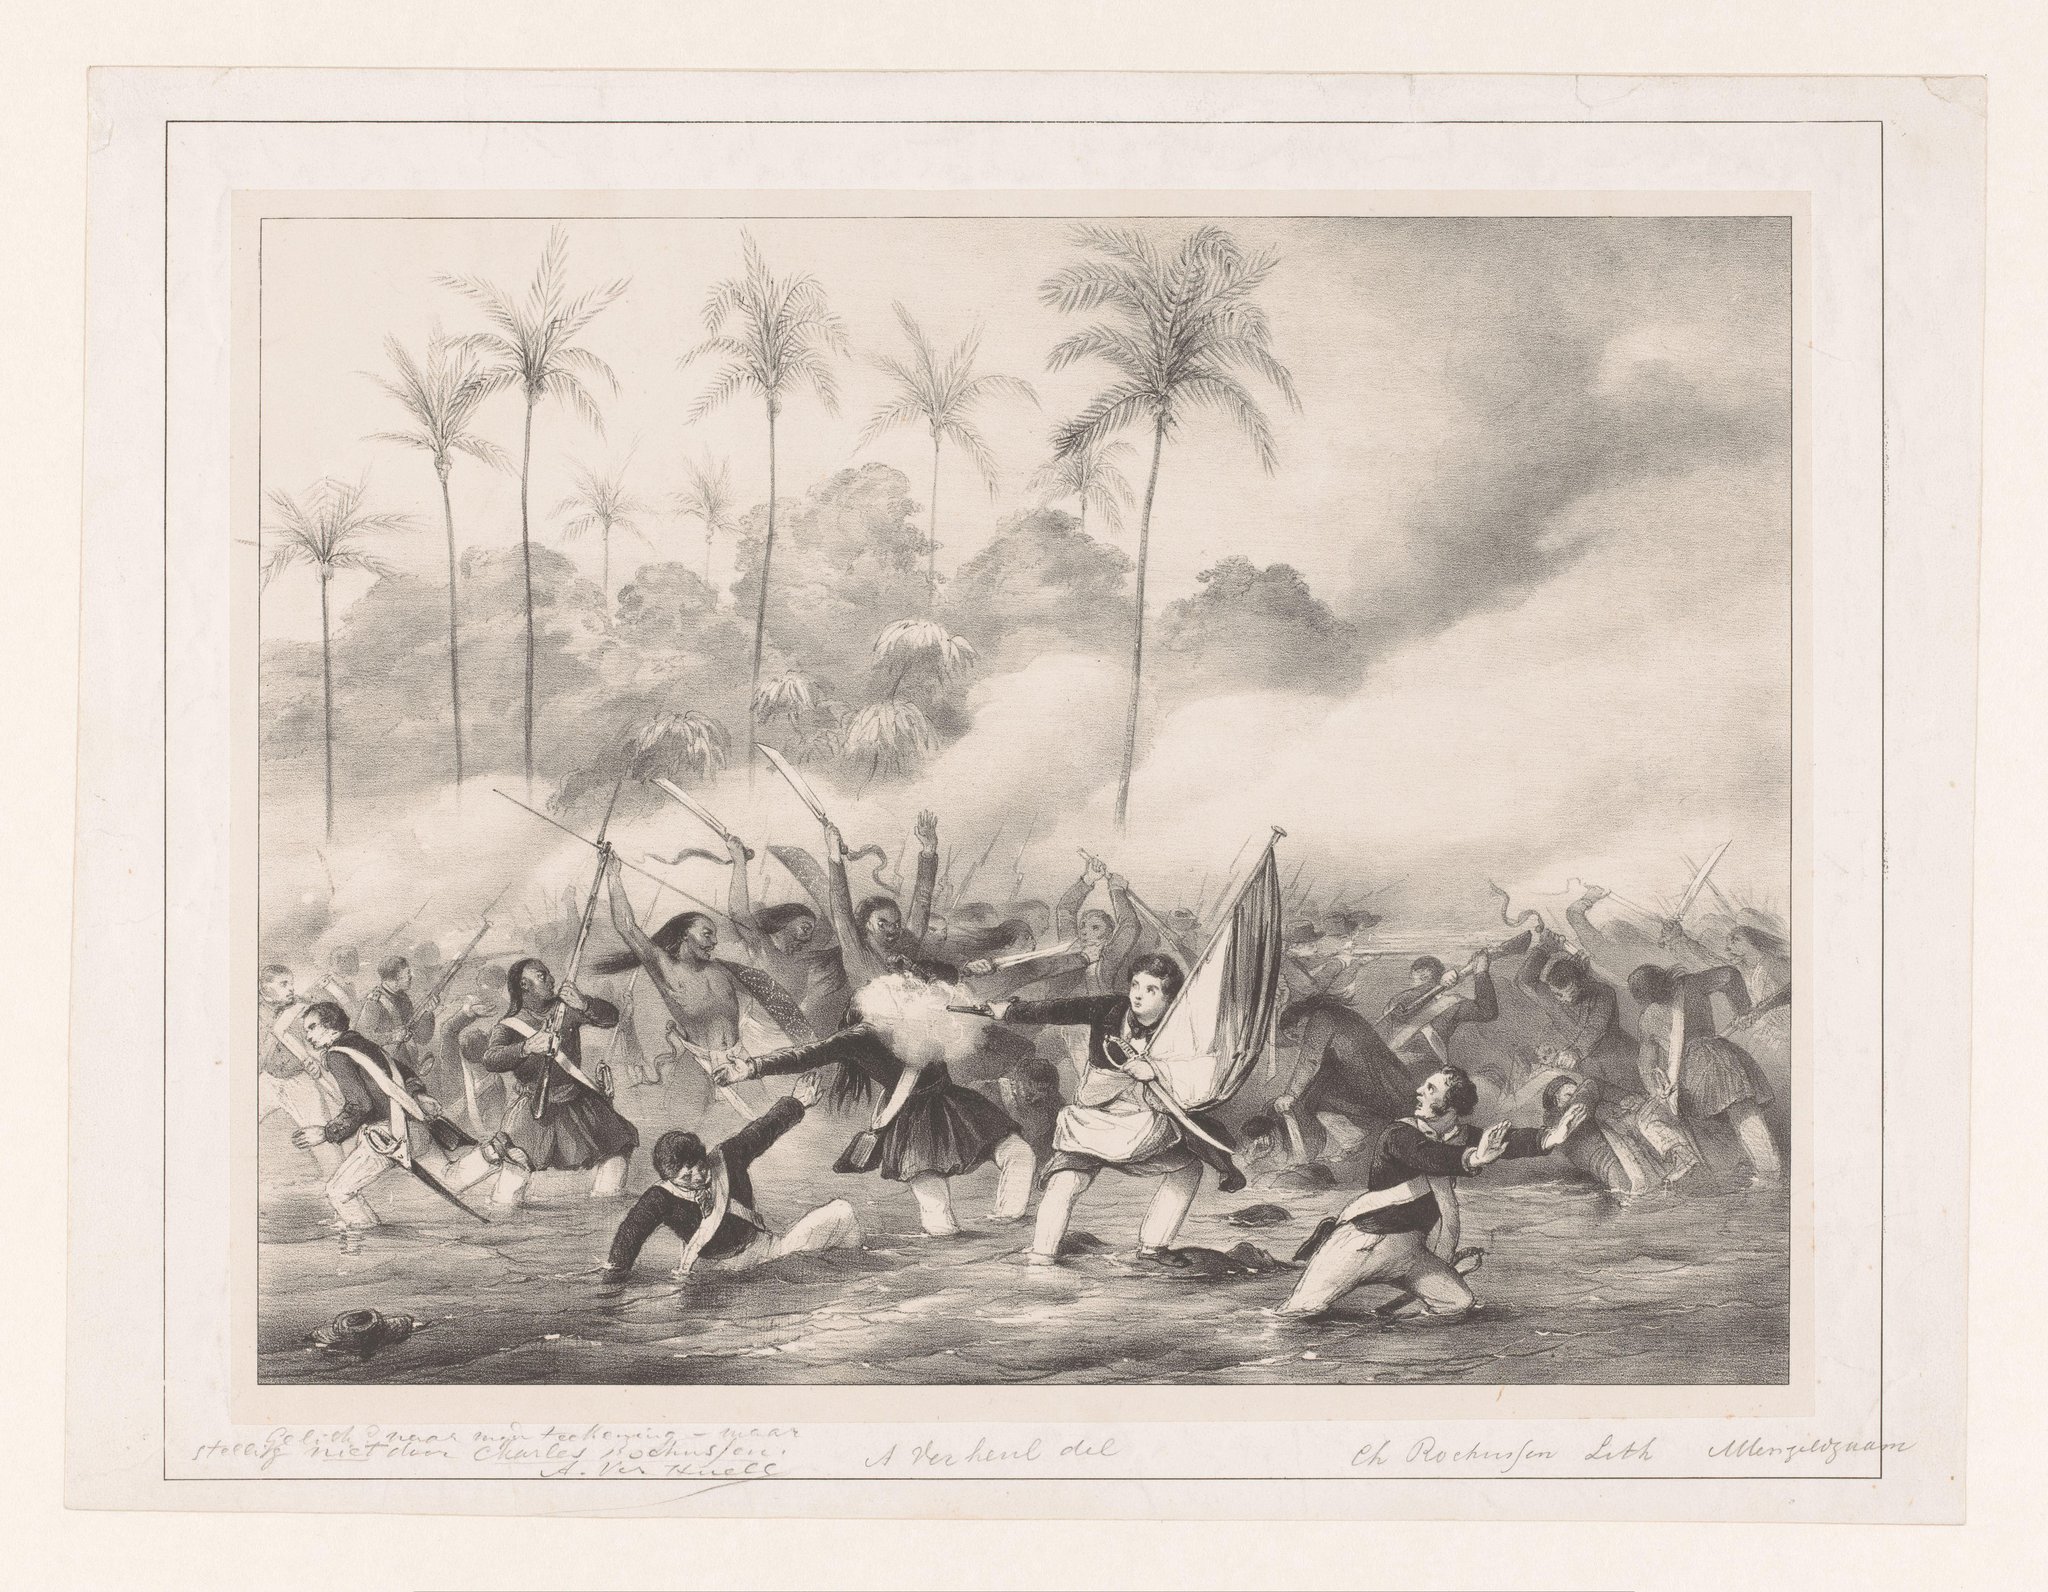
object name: print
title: Nederlanders in gevecht met de bevolking van een onbekend land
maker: charles rochussen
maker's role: draughtsman, painter, print maker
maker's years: 1814-1894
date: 1832-1894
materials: paper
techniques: lithograph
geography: netherlands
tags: violent death by blows, kicks, pricks, etc., battle, europeans (with name)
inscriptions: collector's mark: Lugt 2228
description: In het water zijn Nederlanders in gevecht met de bevolking van een onbekend land. Op de voorgrond schiet een man met de Nederlandse vlag zijn tegenstander neer. In de achtergrond een landschap met palmbomen.